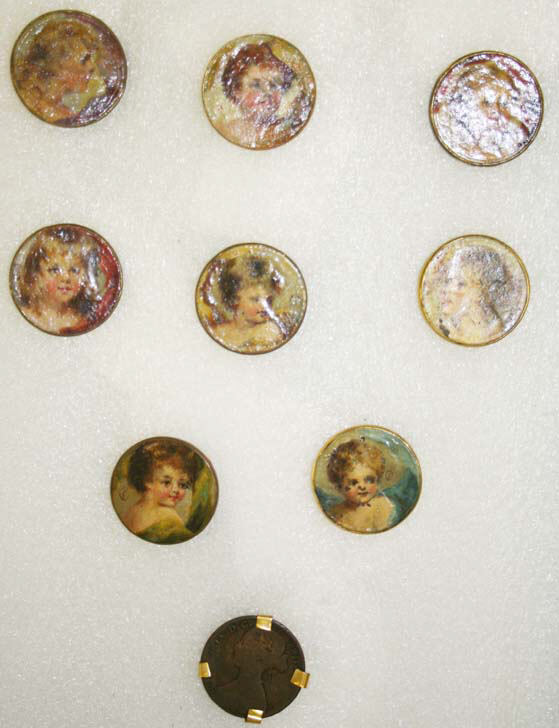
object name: button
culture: british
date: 1860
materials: metal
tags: girls,portraits